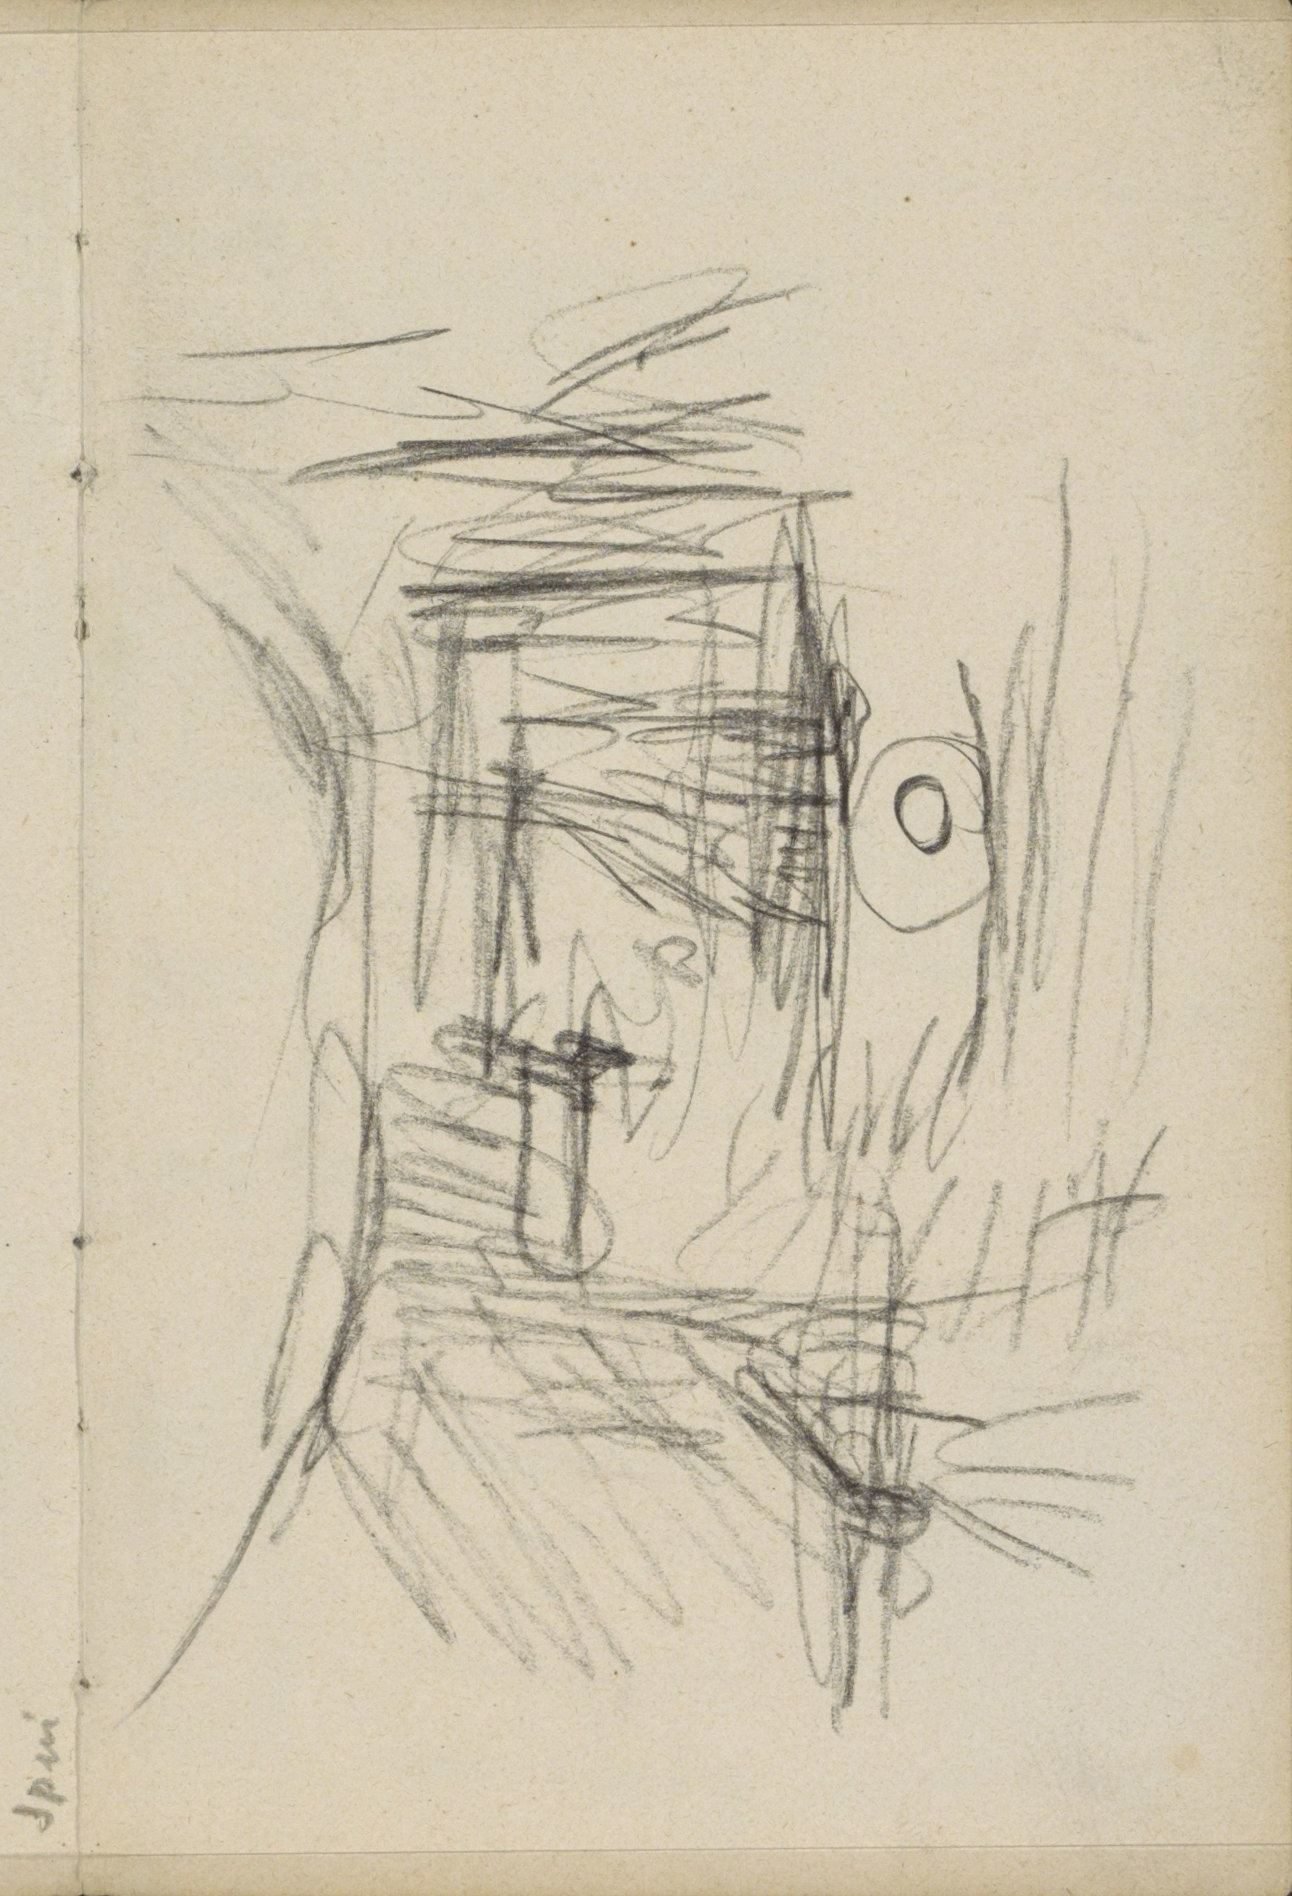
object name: sketchbook leaf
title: Studie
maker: george hendrik breitner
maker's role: draughtsman, painter, print maker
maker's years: 1857-1923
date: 1906-1923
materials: chalk, paper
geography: amsterdam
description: Studie. Pagina 82 uit een schetsboek met 46 bladen vervaardigd in Amsterdam en Haarlem.